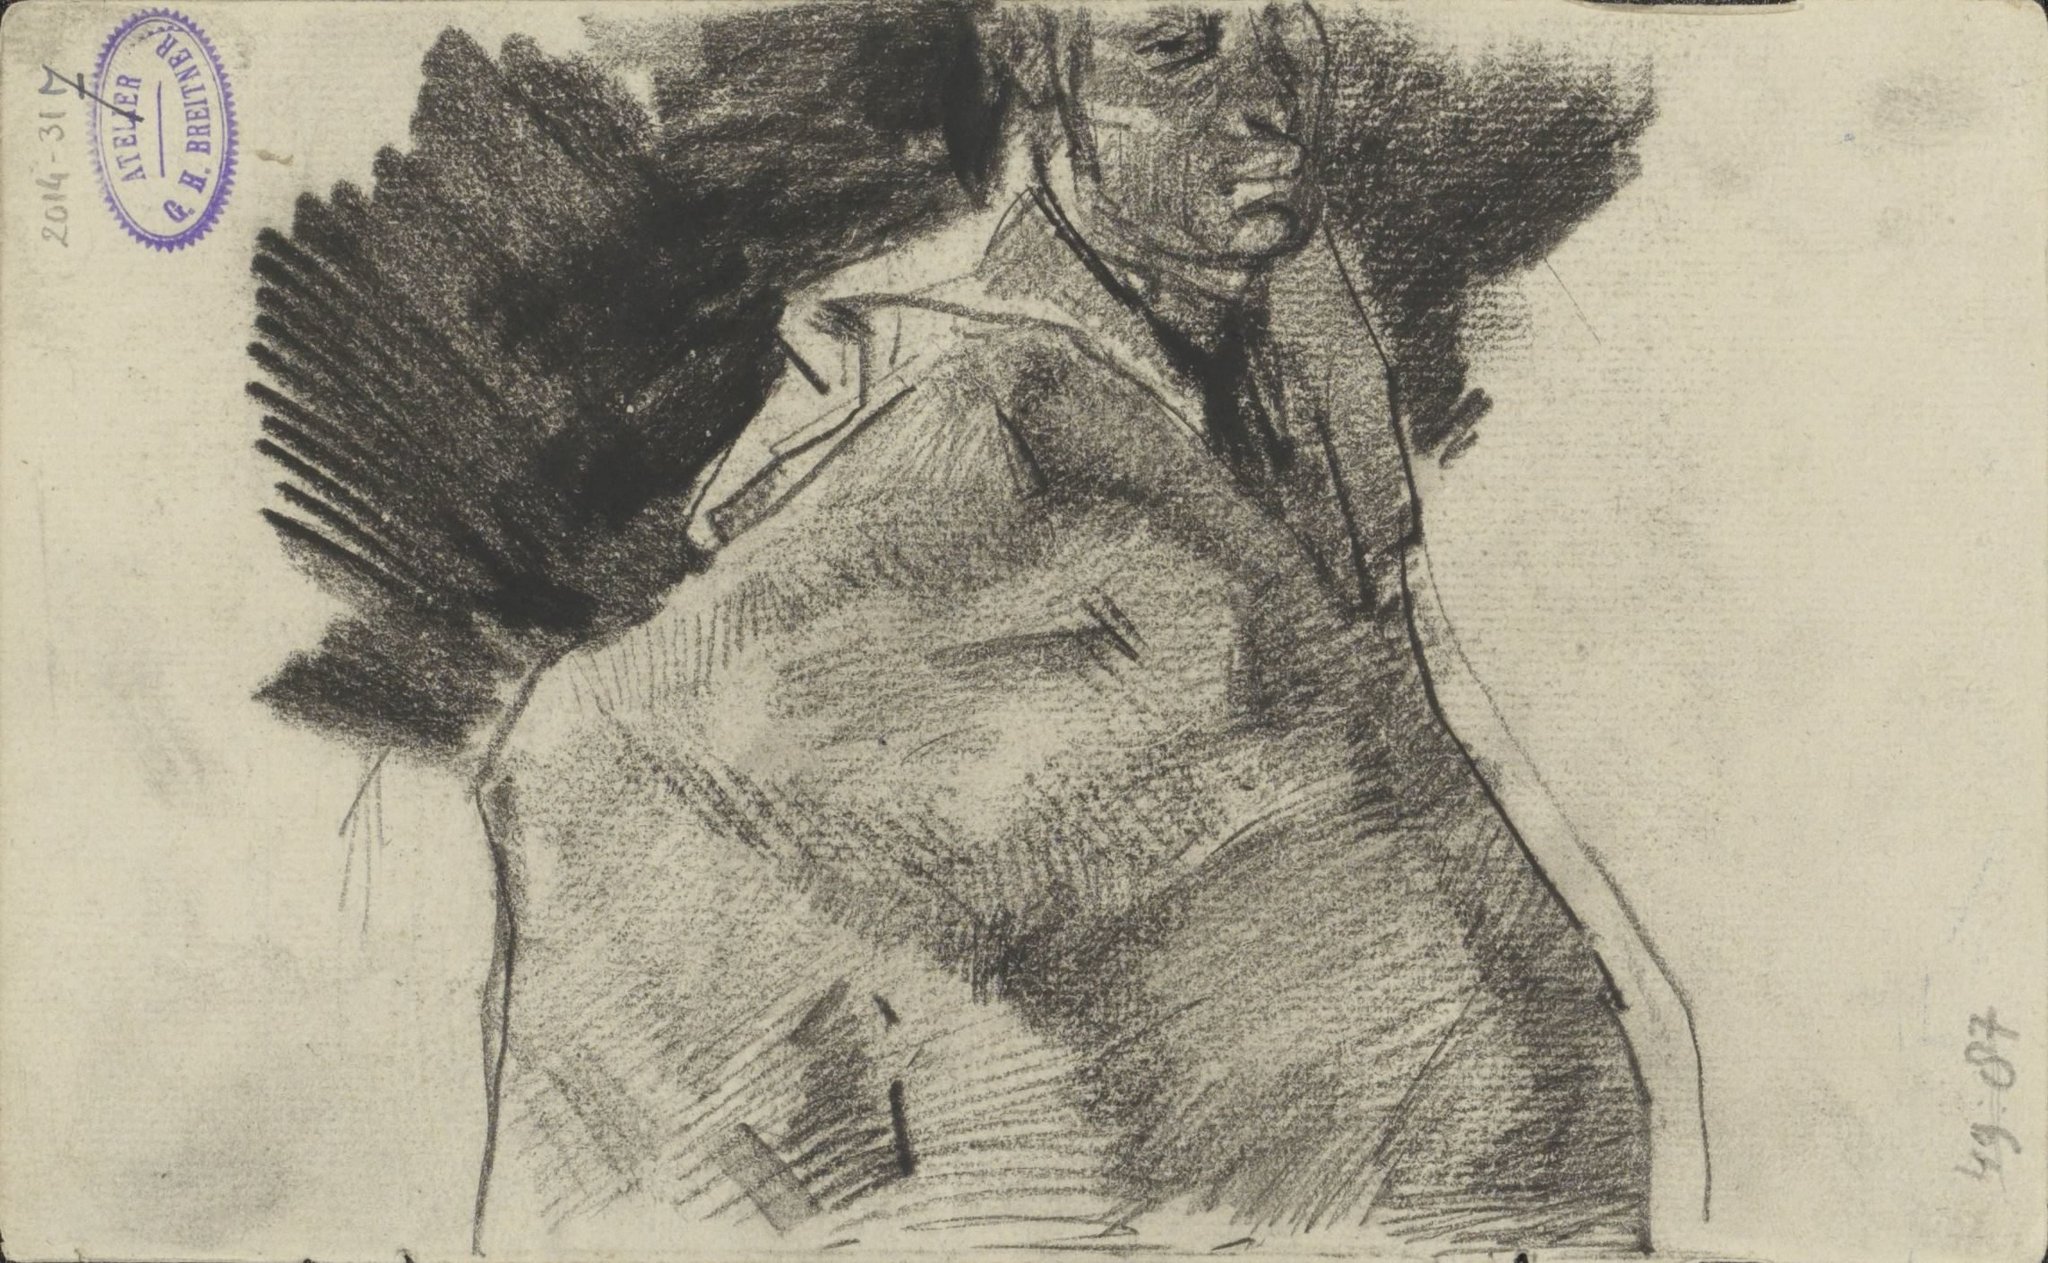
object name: drawing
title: Man in een mantel of cape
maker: george hendrik breitner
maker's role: draughtsman, painter, print maker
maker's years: 1857-1923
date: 1885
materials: chalk, paper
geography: loosduinen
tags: coat (+ men's clothes), adult man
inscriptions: signature: ‘G H Breitner’